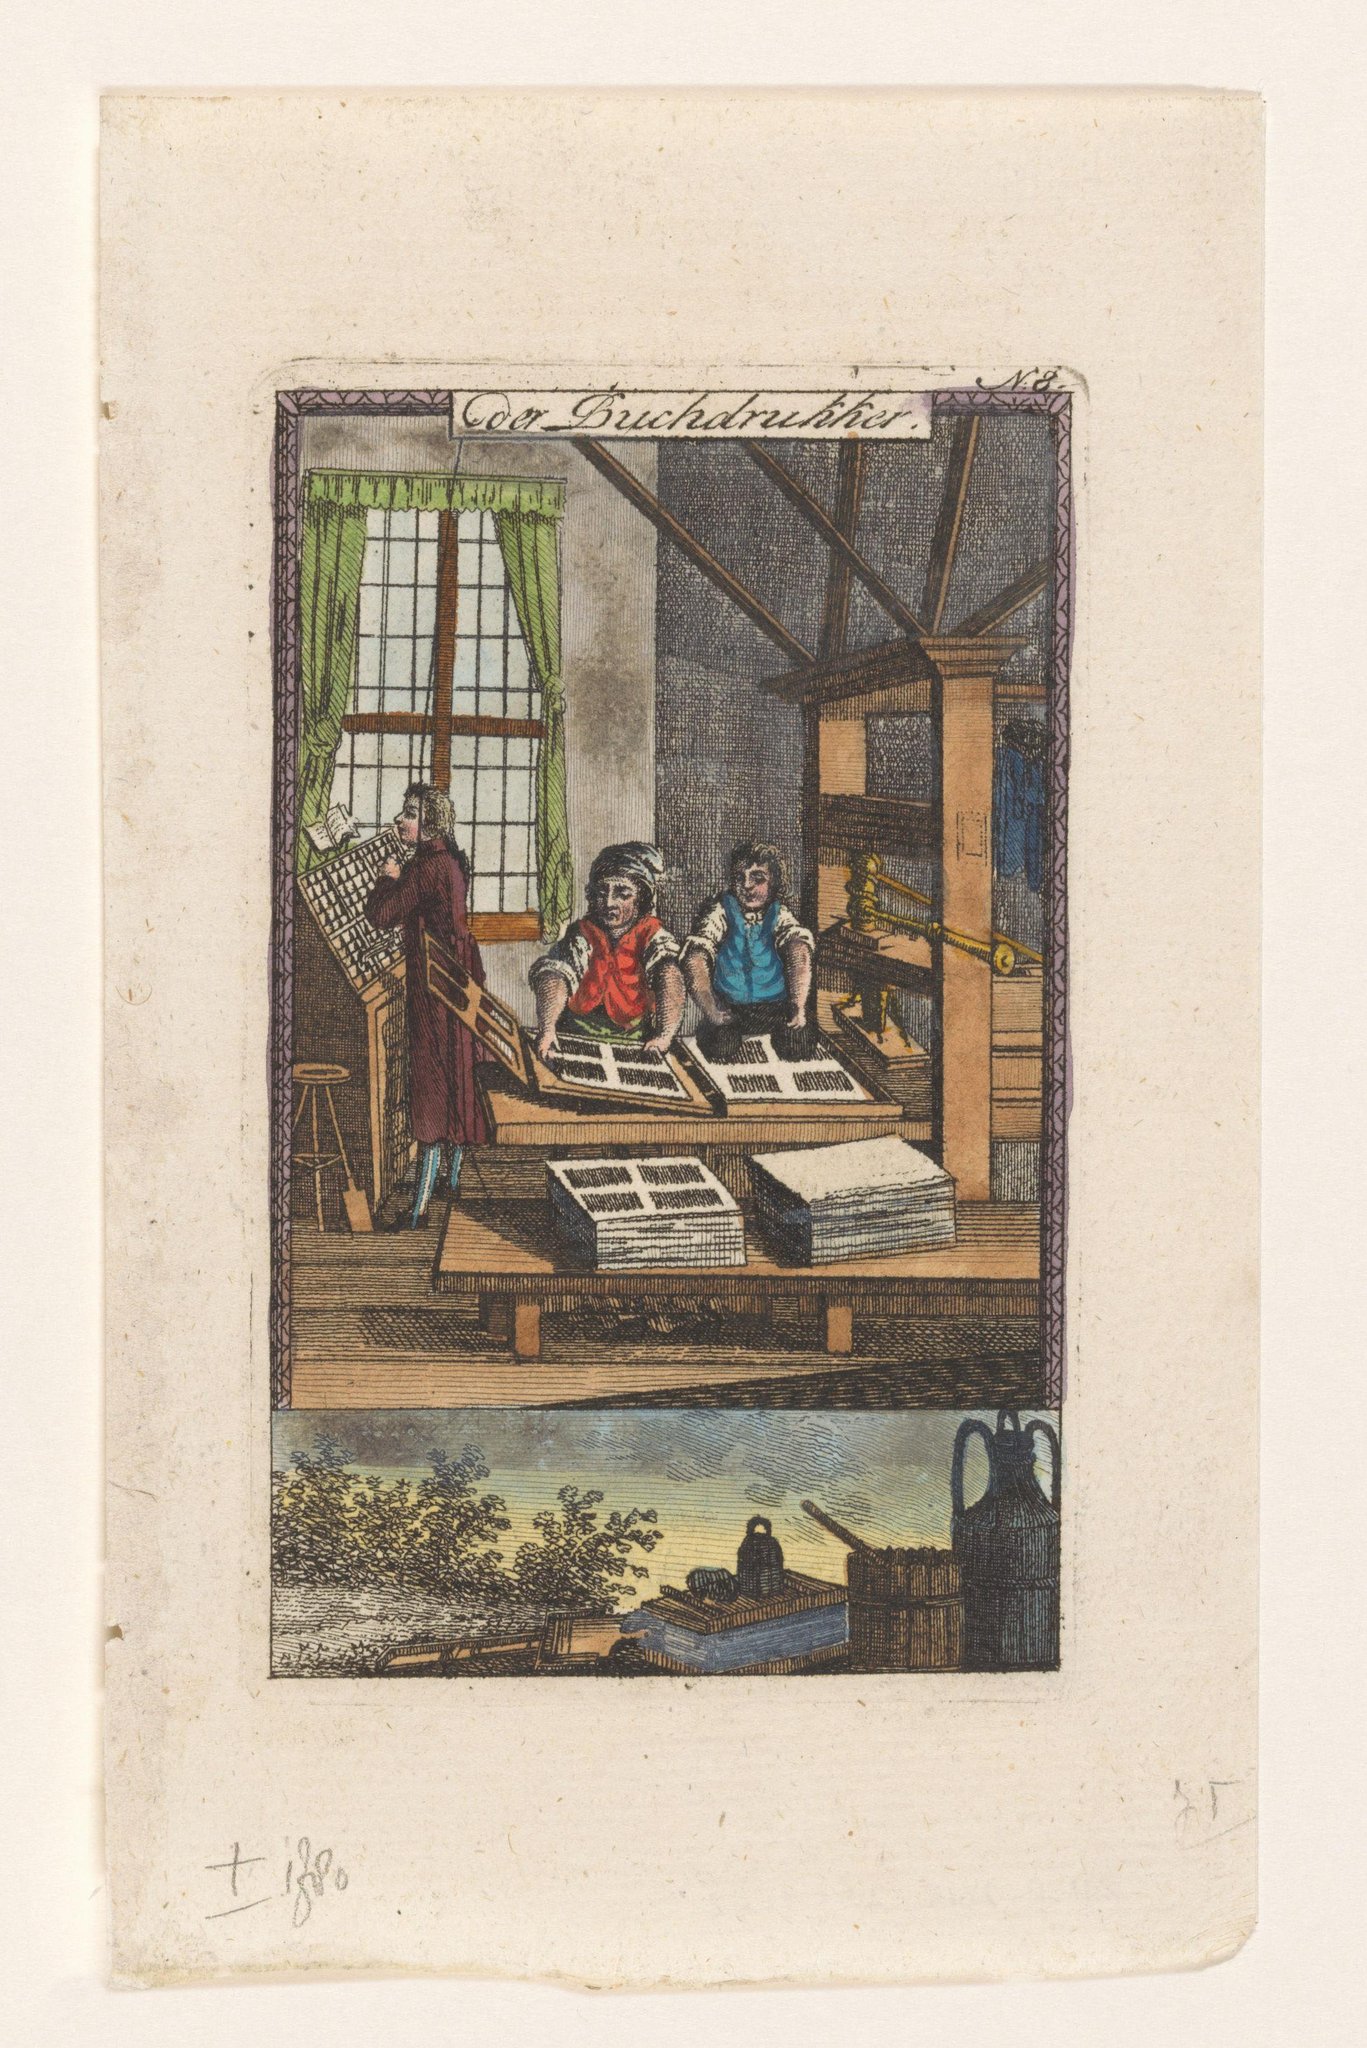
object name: print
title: Der Buchdrukker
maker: Anonymous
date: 1700-1799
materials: paper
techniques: etching, hand coloring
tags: printing press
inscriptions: collector's mark: Lugt 2228, collector's mark: Lugt 4779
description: Interieur van een boekdrukkerij met twee mannen achter een drukpers. Voor het raam staat een man voor een letterkast. Onder het interieur een landschap met enkele objecten, waaronder een stapel papier onder een pers. Rechtsboven genummerd: N. 8.